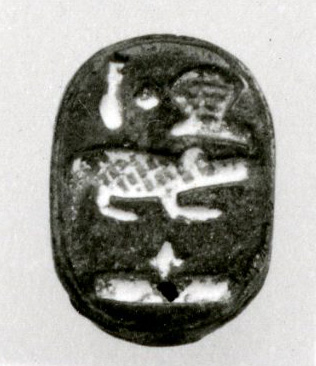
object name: scarab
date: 1295-1070 BCE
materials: stone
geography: egypt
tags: scarabs